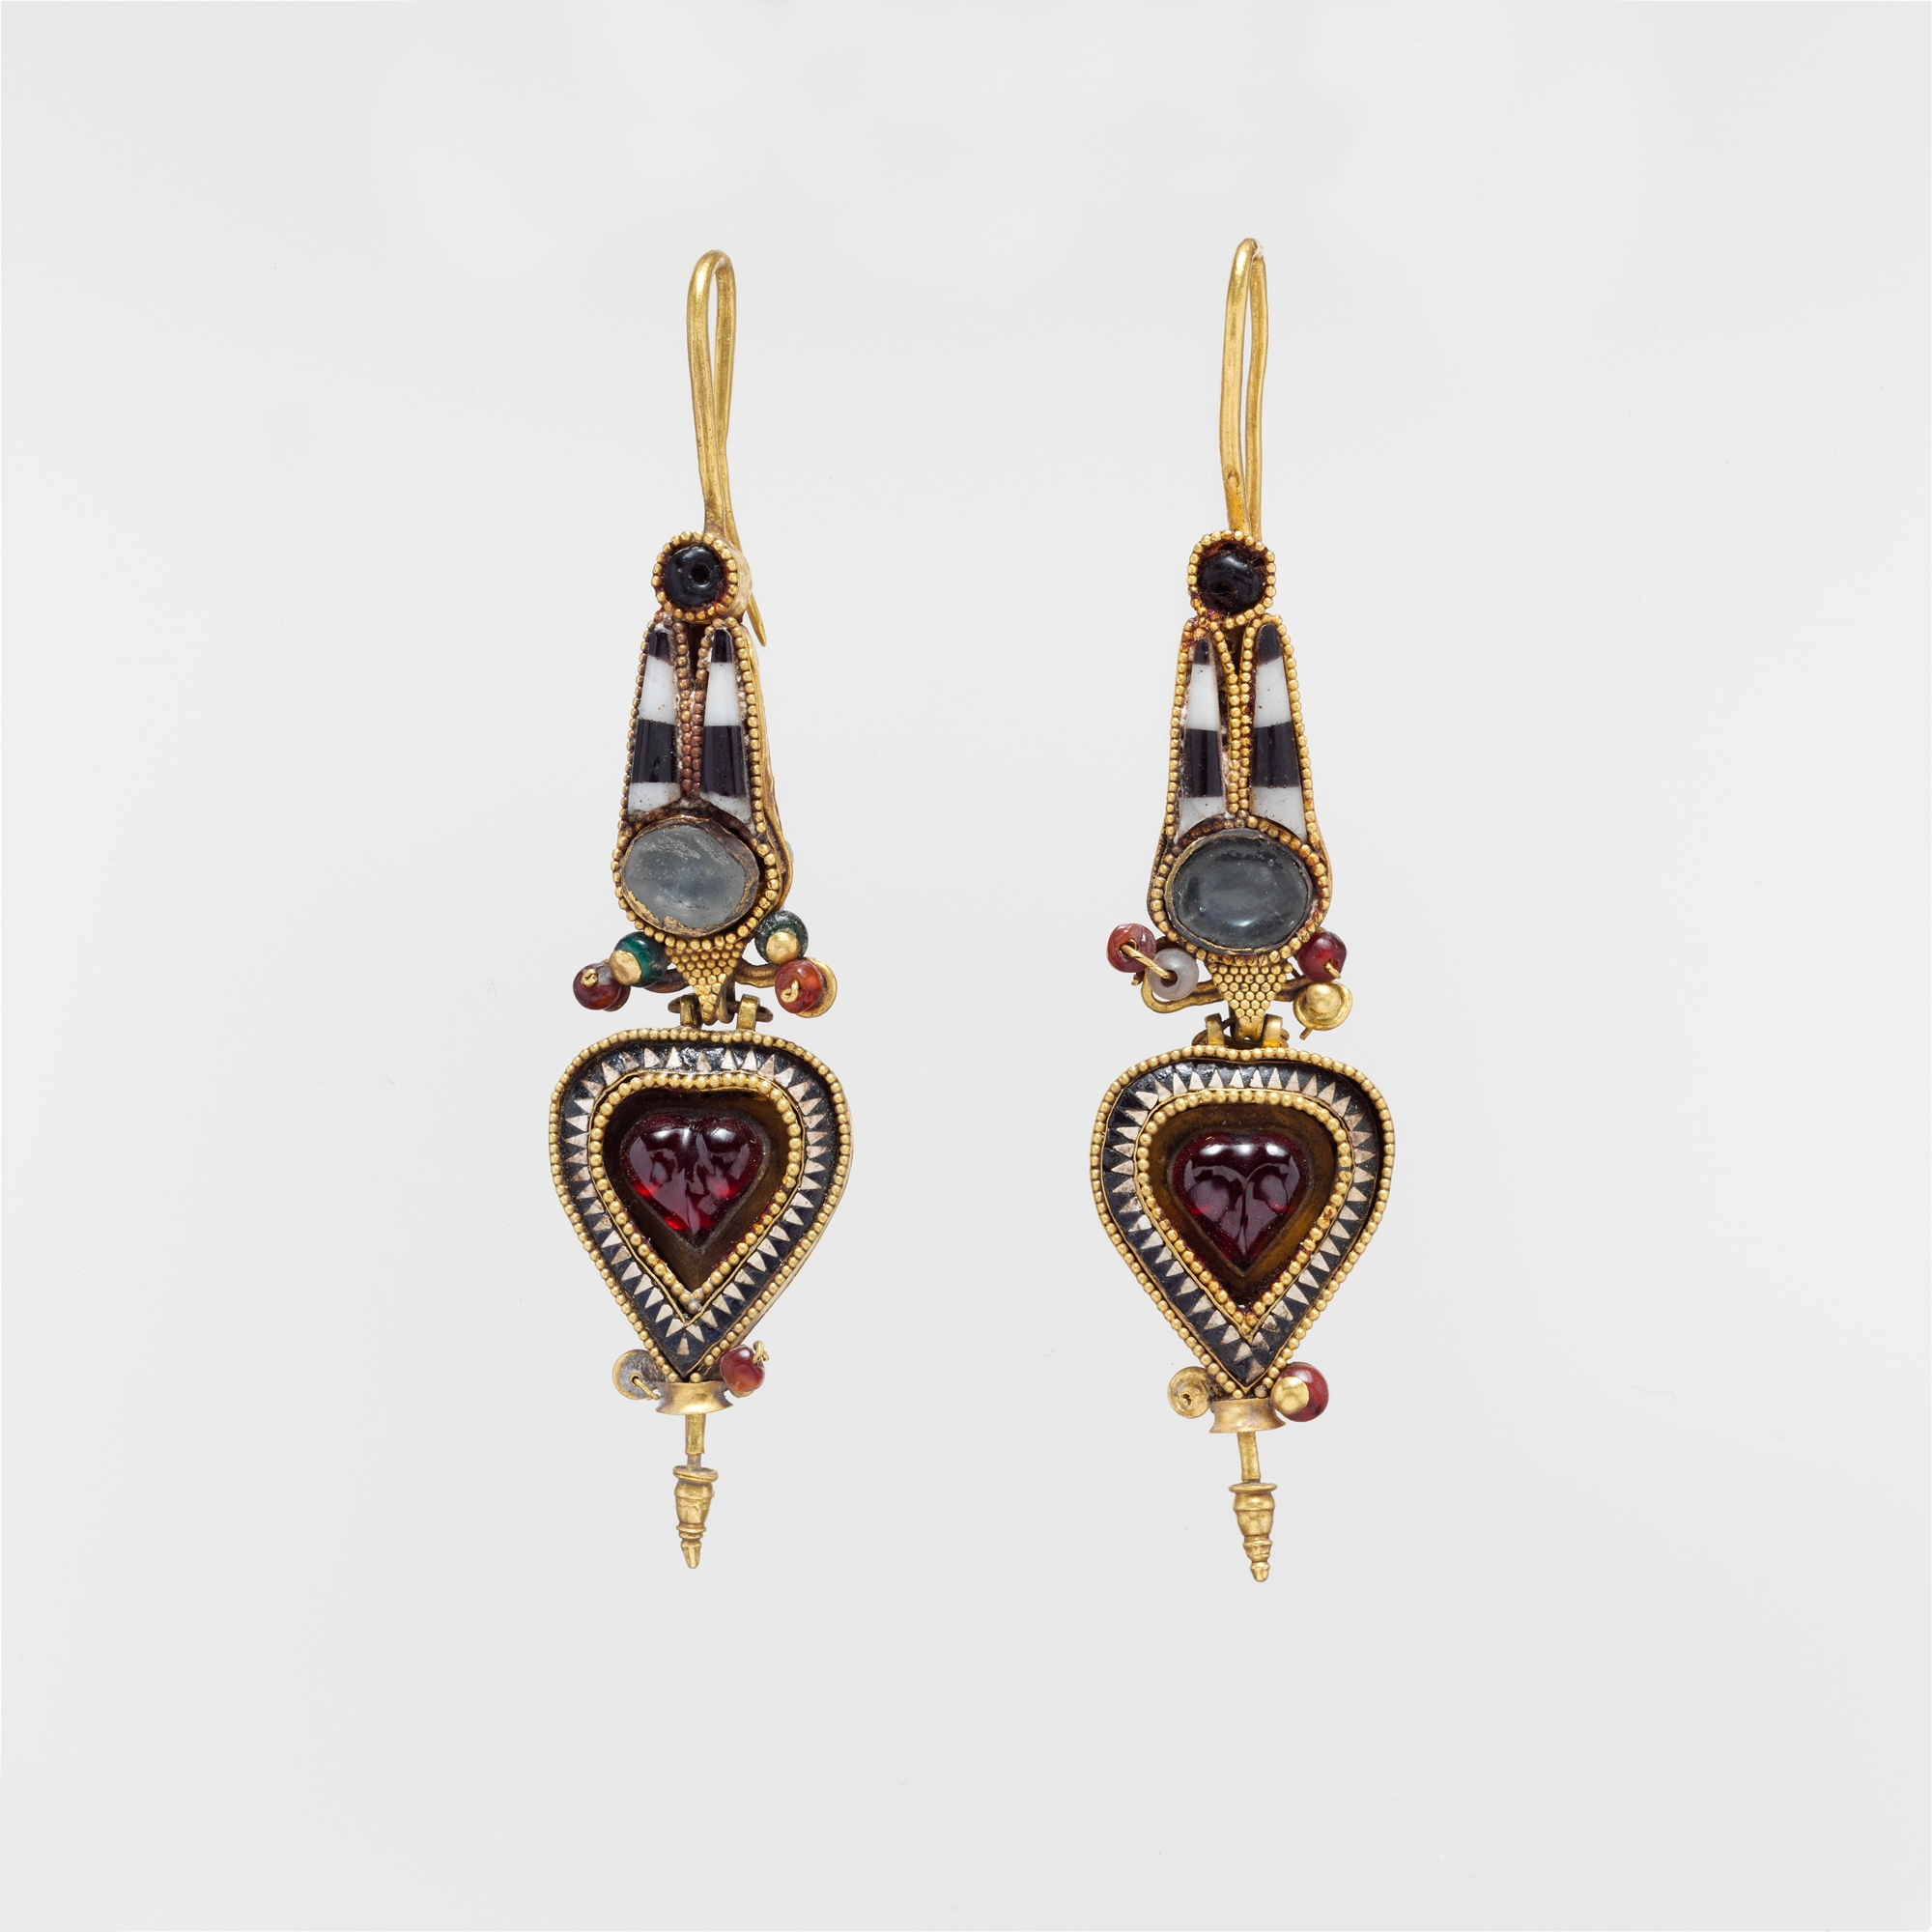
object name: earring with egyptian atef crown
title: Pair of gold earrings with an Egyptian Atef crown set with stones and glass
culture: greek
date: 300-101 BCE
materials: glass, gold, stone